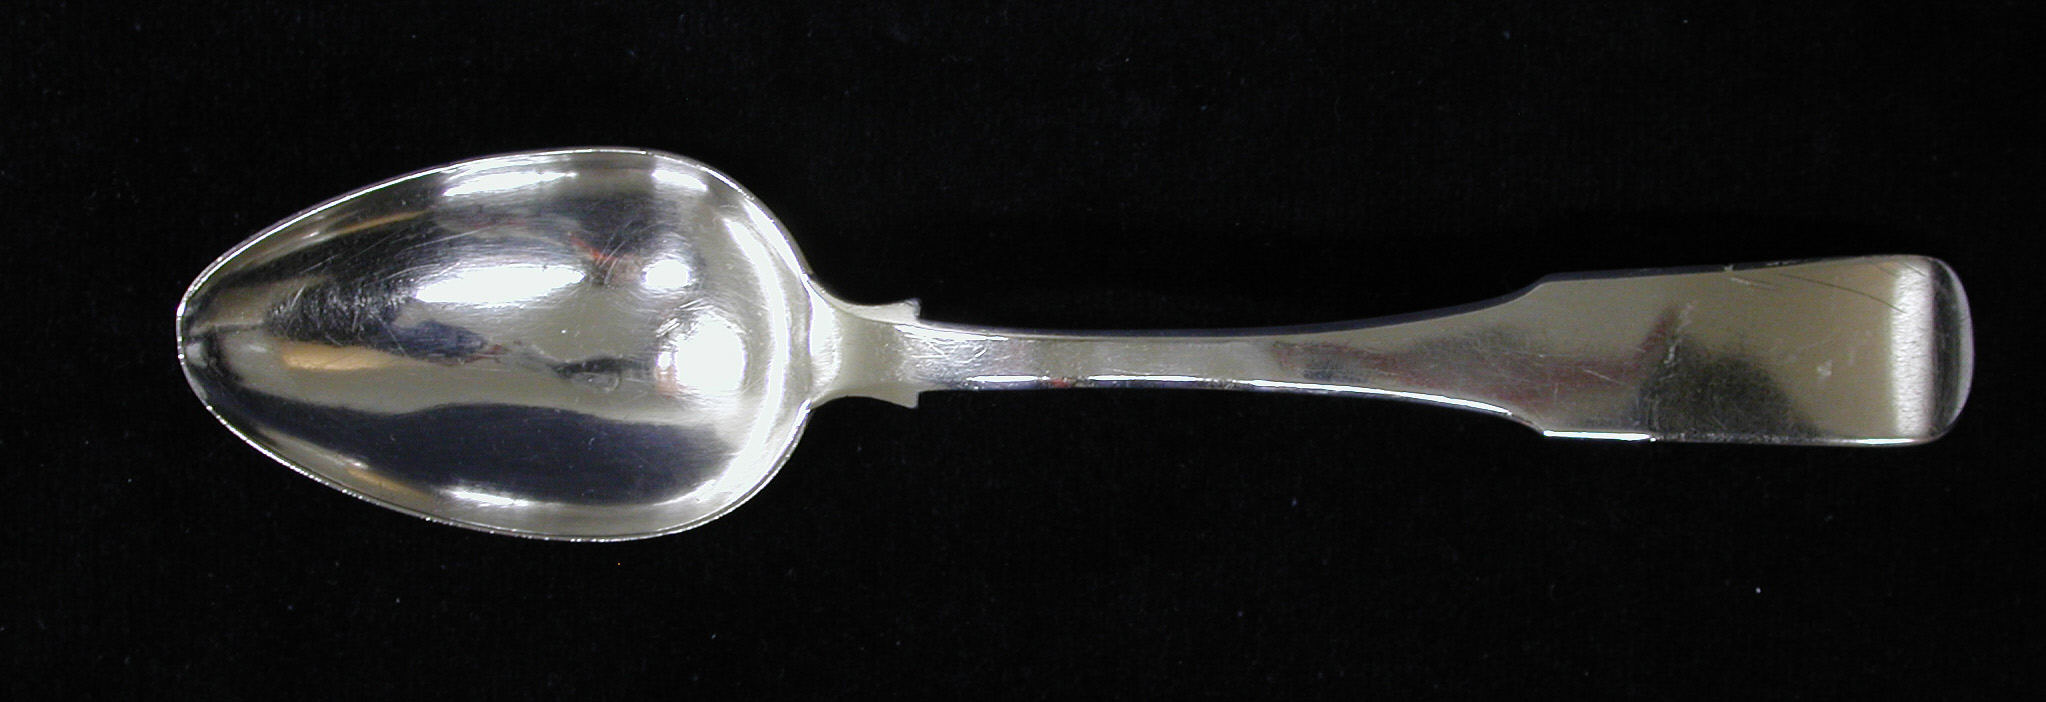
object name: tablespoon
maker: m. hoyris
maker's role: maker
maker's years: 1800-1900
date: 1840-1850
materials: silver